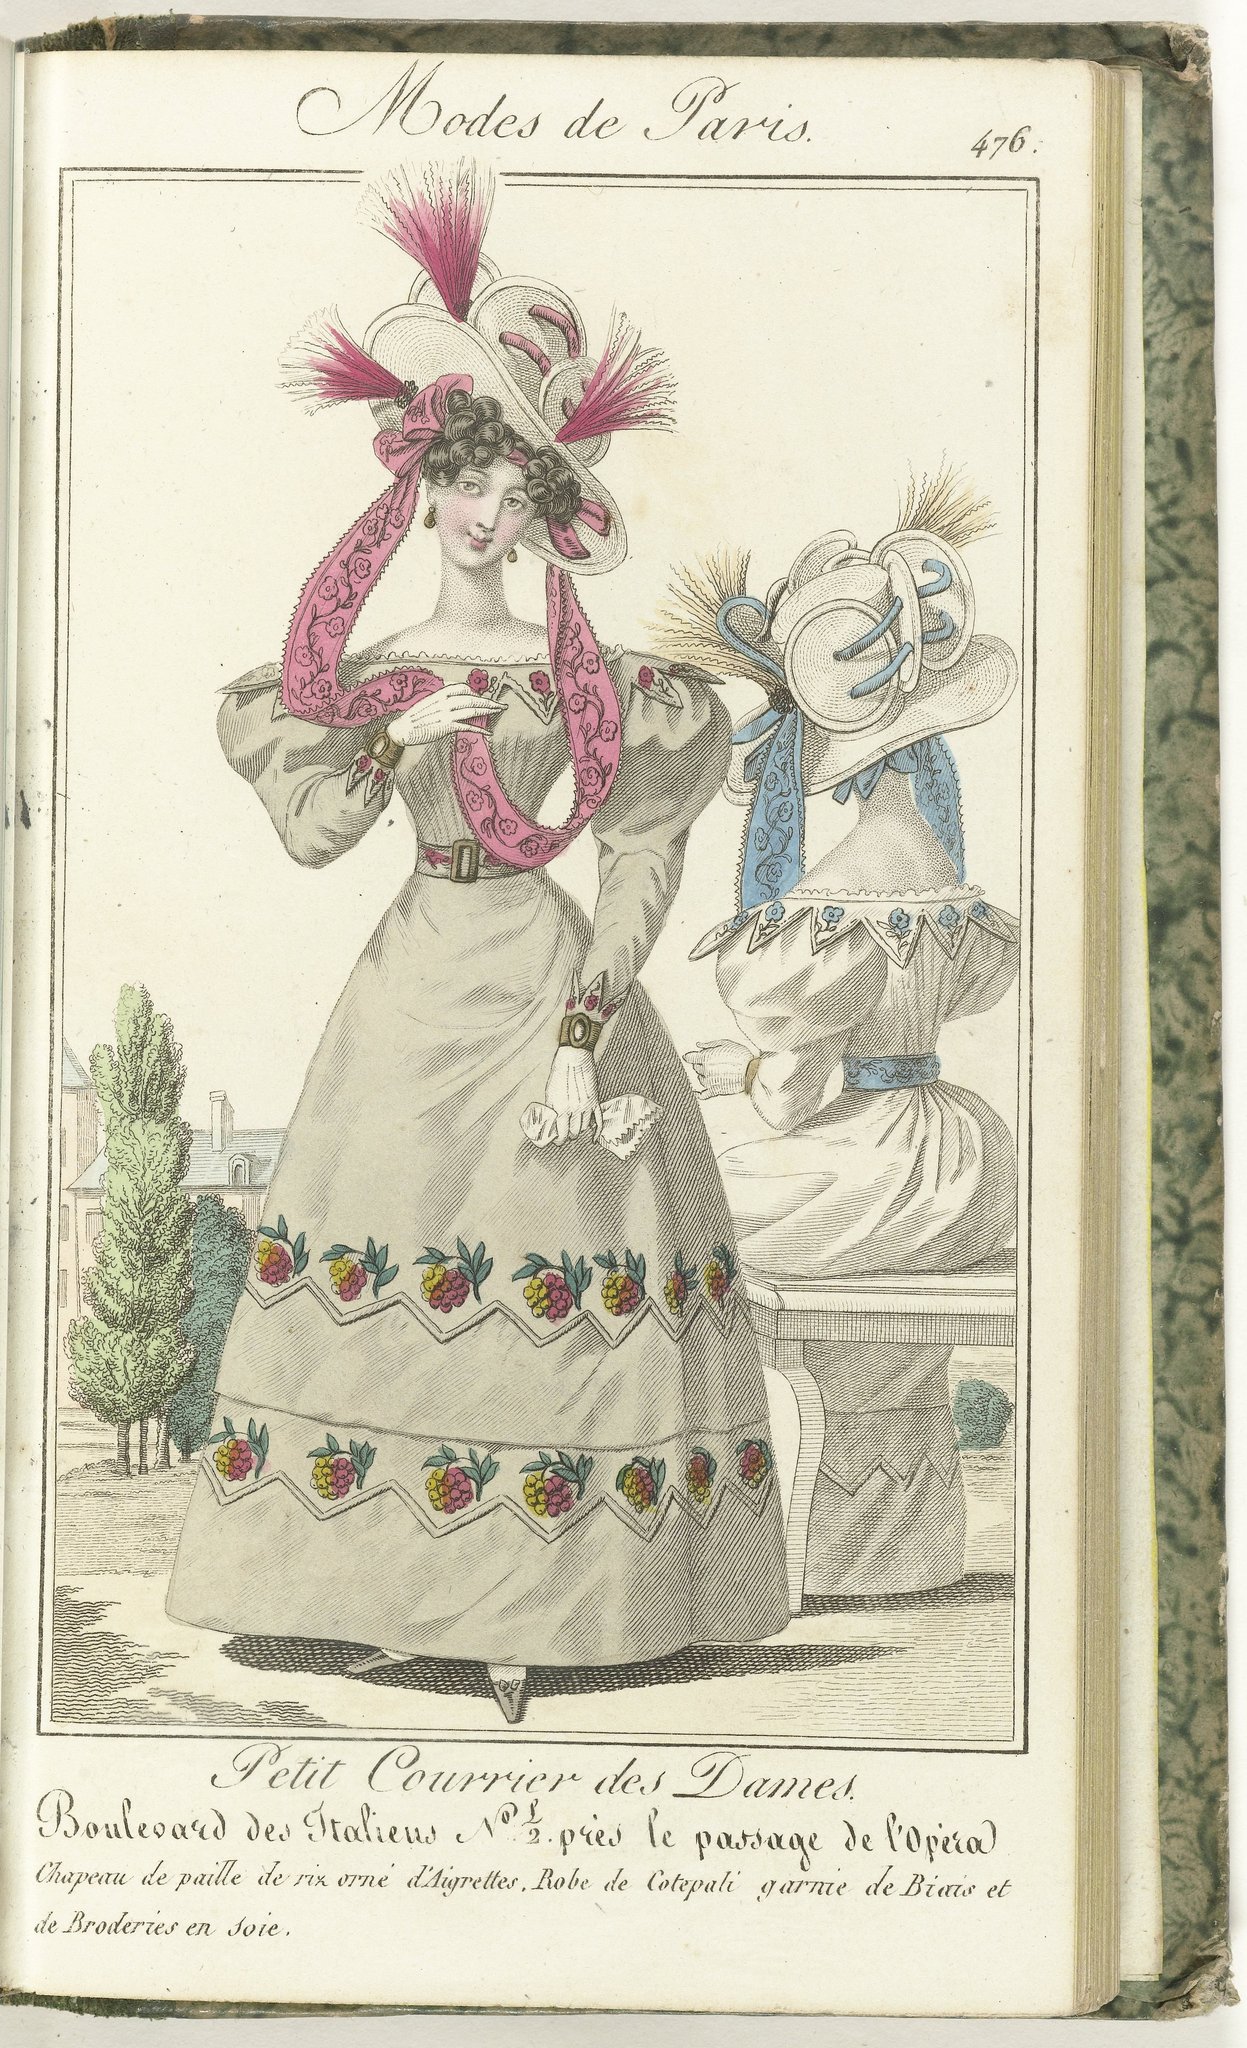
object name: fashion print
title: Petit Courrier des Dames, 10 juin 1827, No. 476 : Chapeau de paille de riz...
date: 1827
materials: paper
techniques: engraving, hand coloring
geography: paris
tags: handkerchief (+ women's clothes), pin (+ women's clothes), buckle (+ women's clothes), fashion plates, head-gear: hat (+ women's clothes), gloves, mittens, etc. (+ women's clothes), dress, gown (+ women's clothes), bracelet, wristlet (+ women's clothes)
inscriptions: title: ‘Modes de Paris.’, caption: ‘Chapeau de paille de riz orné d'Aigrettes. Robe de Cotepali garnie de Biais et de Broderies en soie.’, title: ‘Petit Courrier des Dames.’, address: ‘Boulevard des Italiens No.2 près le passage de l'Opèra.’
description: Staande vrouw gekleed in een japon van cotepali versierd met een biais en borduursels van zijde. Op het hoofd een hoed van 'paille de riz' versierd met aigrettes. Zakdoek in de hand. Rechts een zittende vrouw, op de rug gezien, gekleed in eenzelfde japon. Prent uit het modetijdschrift Petit Courrier des Dames (1821-1868). Ingebonden (met enkele pp. Le Journal des Dames et des Modes). 15 Januari 1827 t/m 20 maart 1830. Incompleet.